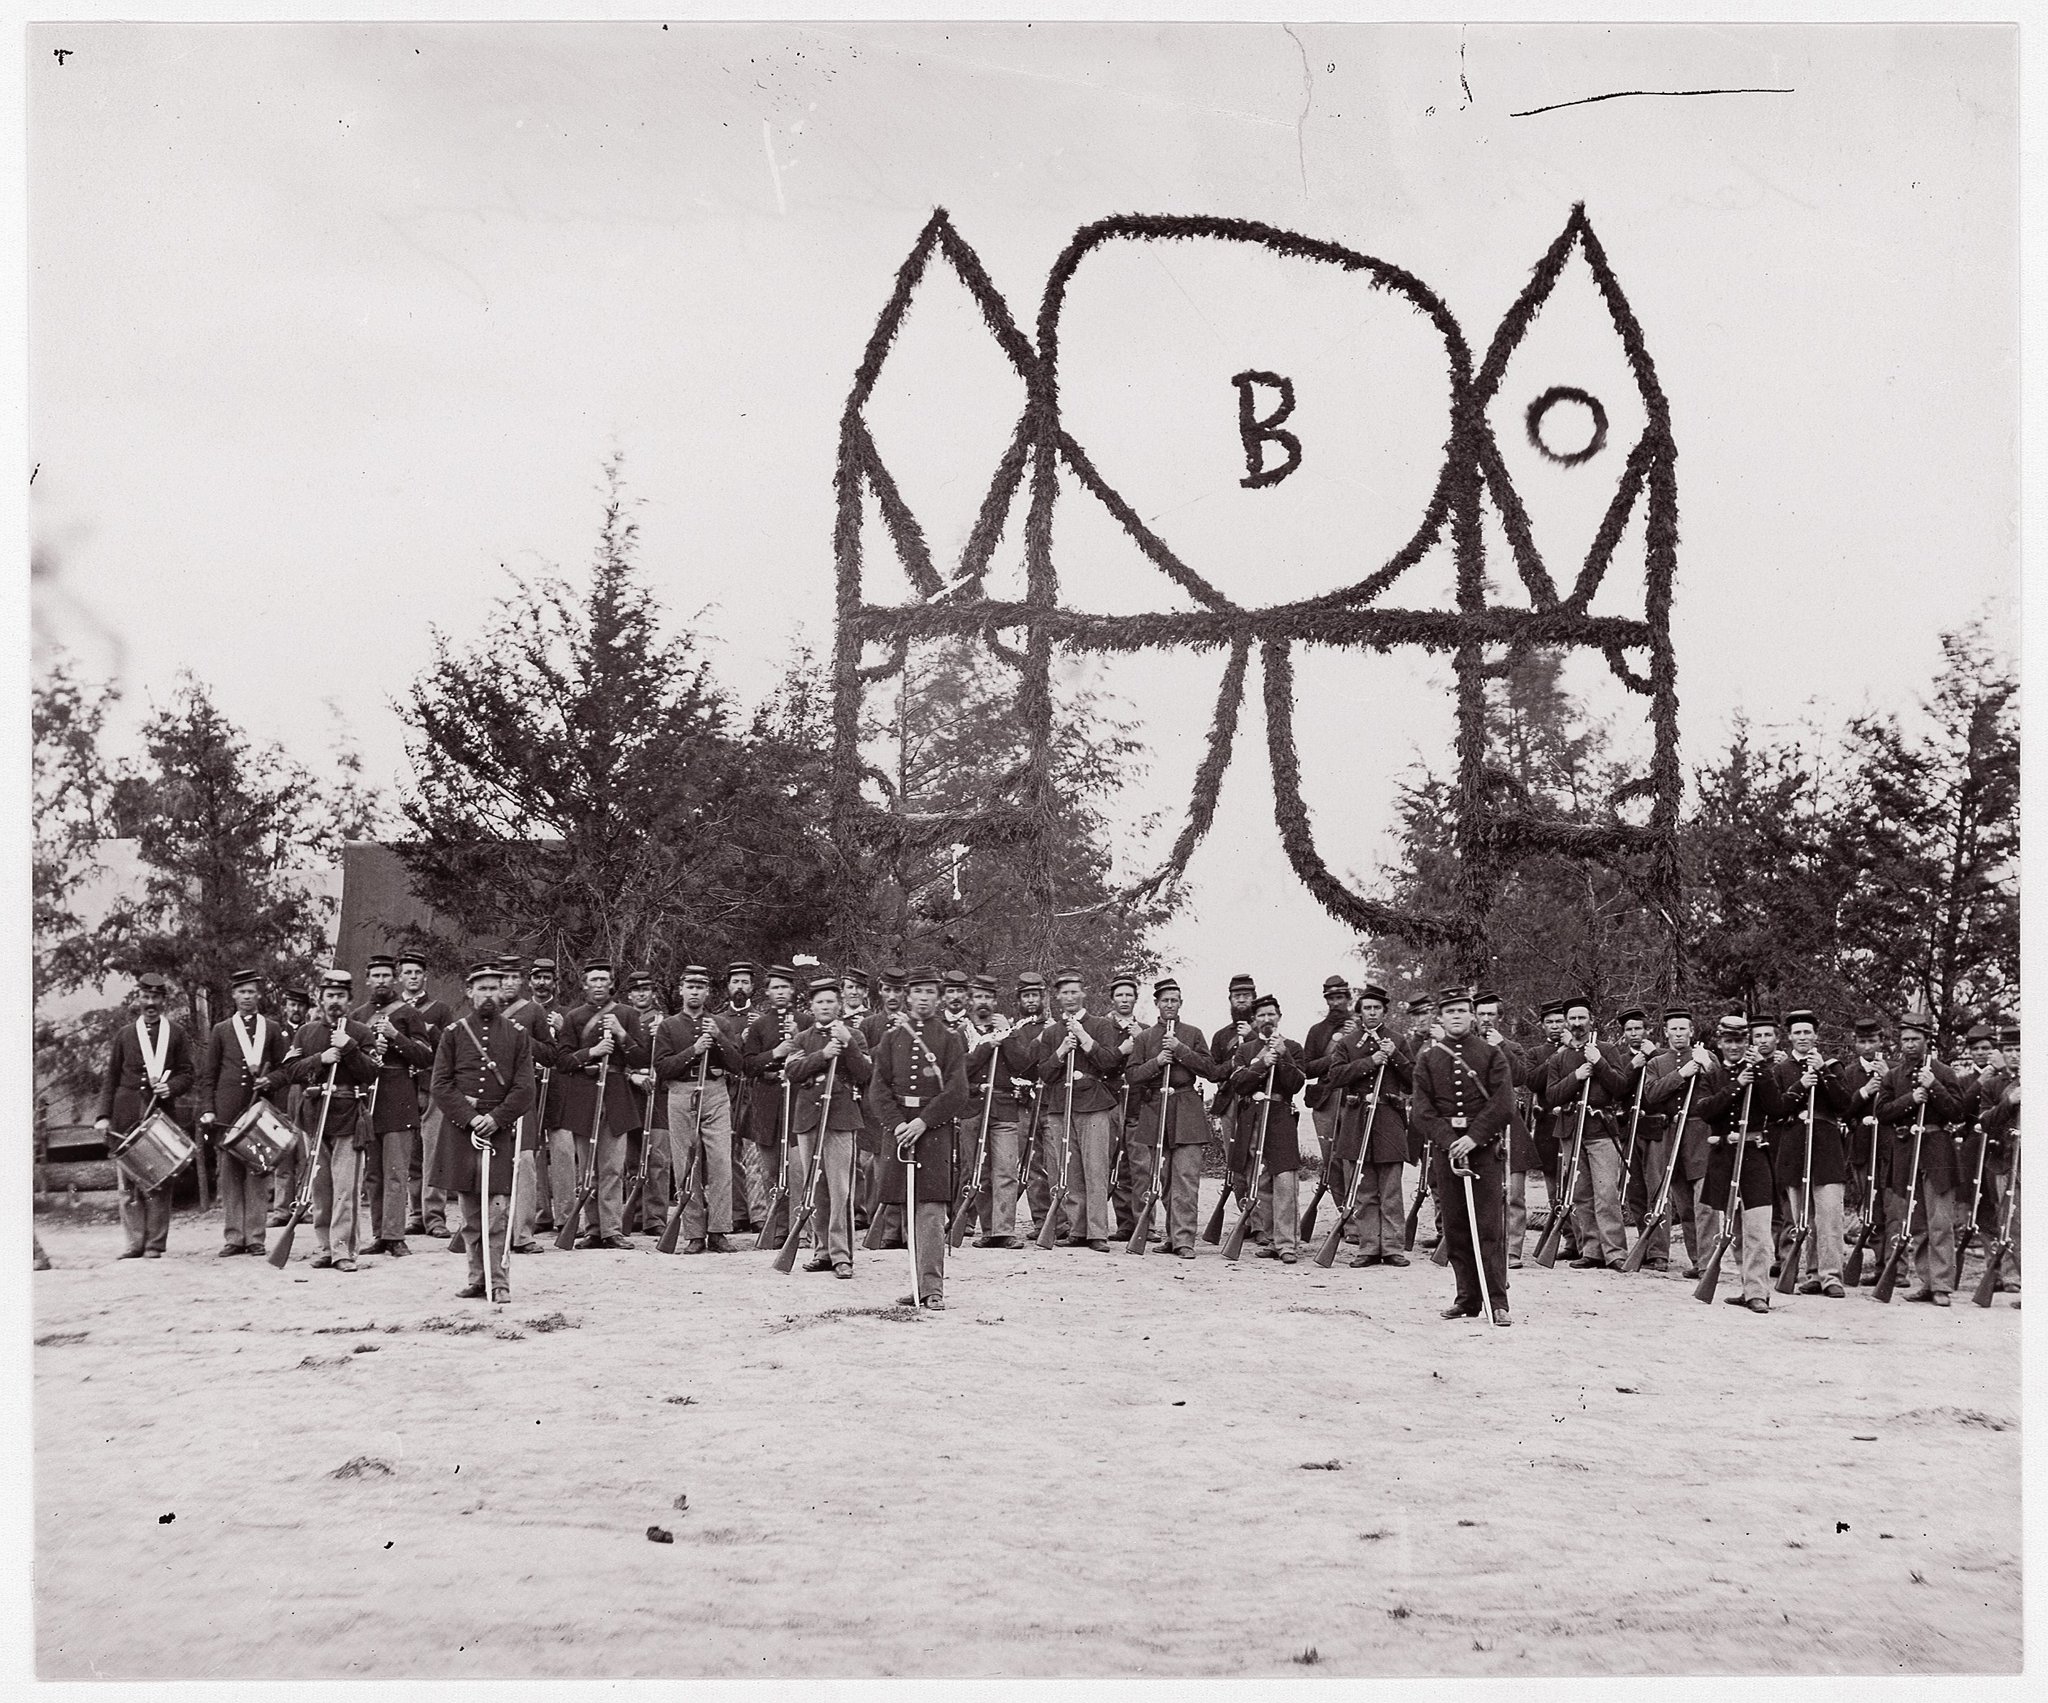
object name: photograph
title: Co. B, 30th Pennsylvania Infantry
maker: Anonymous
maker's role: artist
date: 1861-1865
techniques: albumen silver print, glass negative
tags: army,soldiers,firearms,drums